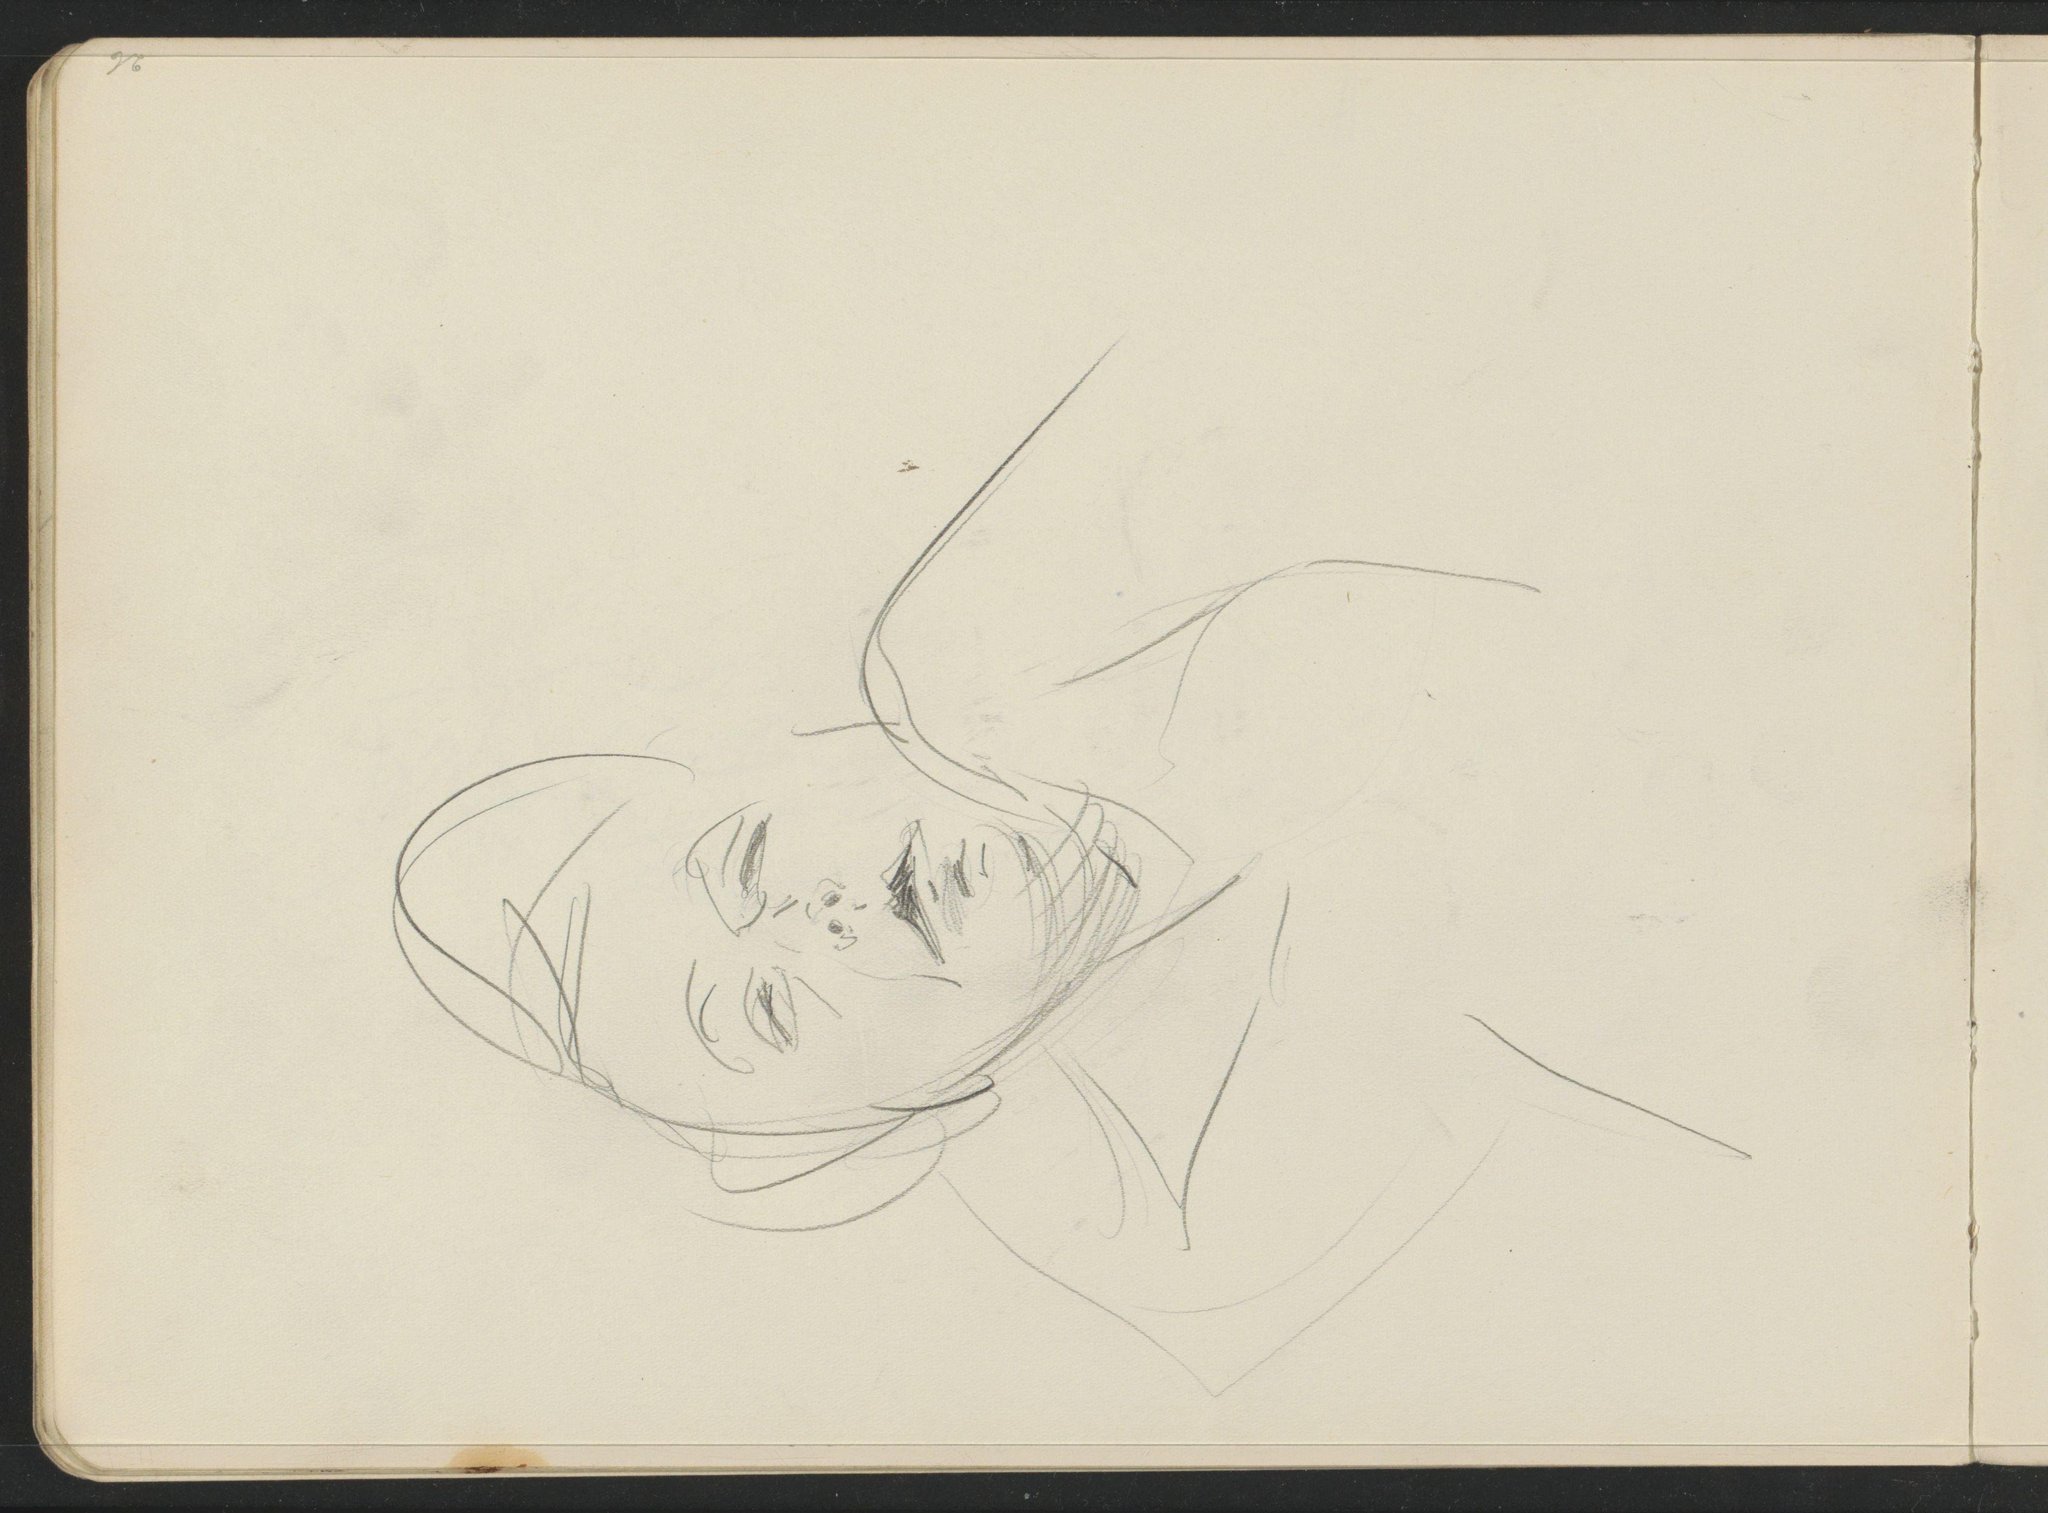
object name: sketchbook leaf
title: Vrouw met een arm achter haar hoofd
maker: isaac israels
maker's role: draughtsman, painter, print maker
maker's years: 1865-1934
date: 1915-1934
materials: paper, pencil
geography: the hague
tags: hand behind the head (+ female (human being) (not to be used where -aa- is prescribed))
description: Blad 19 verso uit schetsboek XV met 22 bladen.